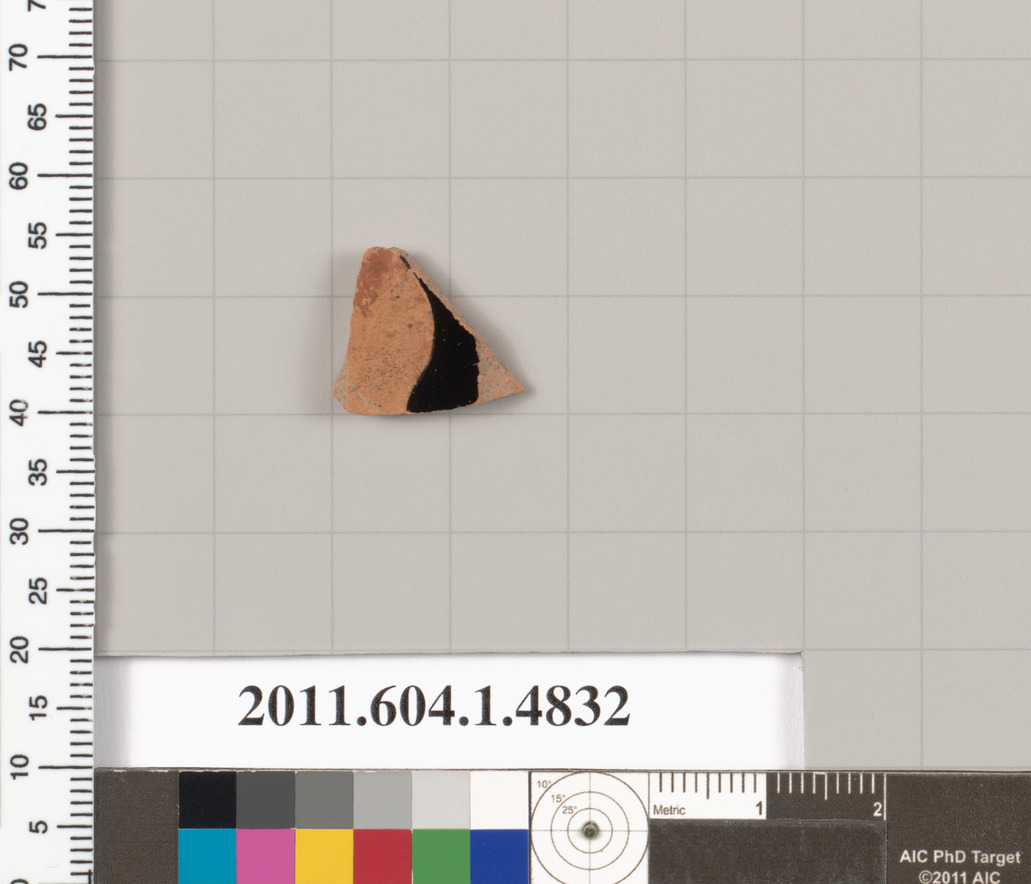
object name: kylix fragment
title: Terracotta fragment of a kylix (drinking cup)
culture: greek, attic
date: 500-480 BCE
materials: terracotta